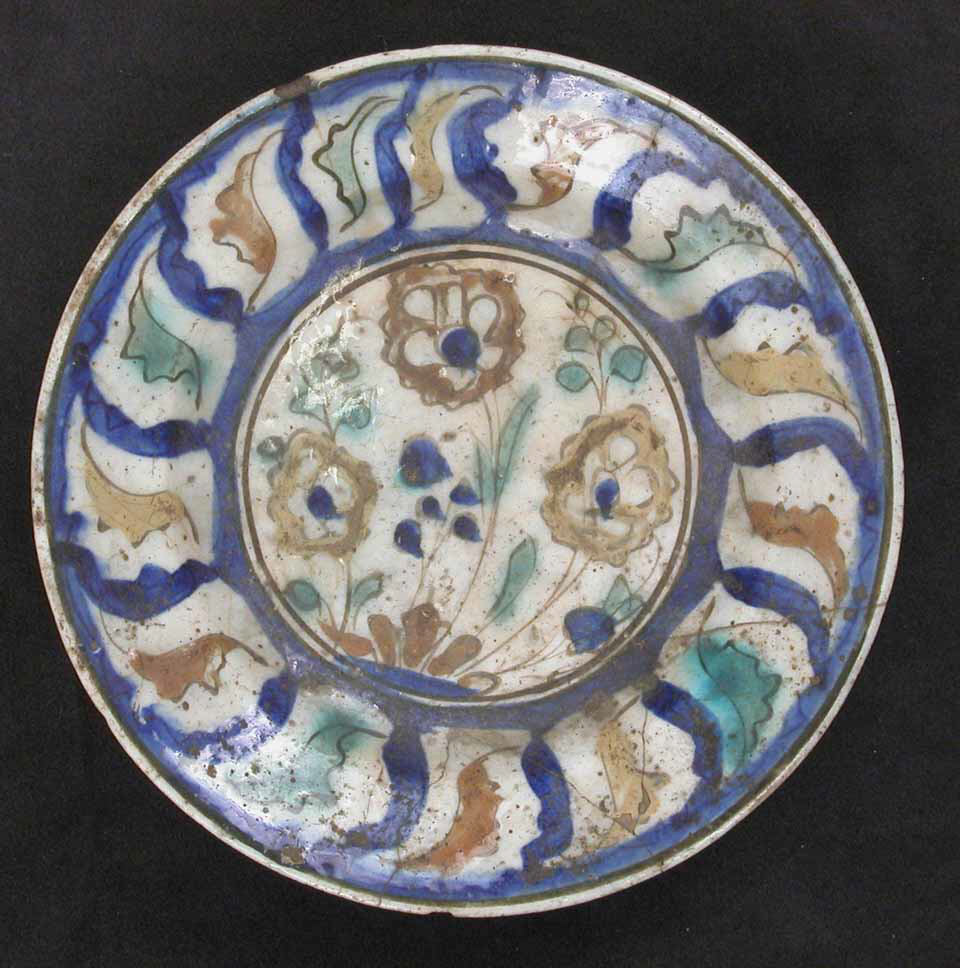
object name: dish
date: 1601-1800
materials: stonepaste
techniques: painting, underglaze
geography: iran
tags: flowers